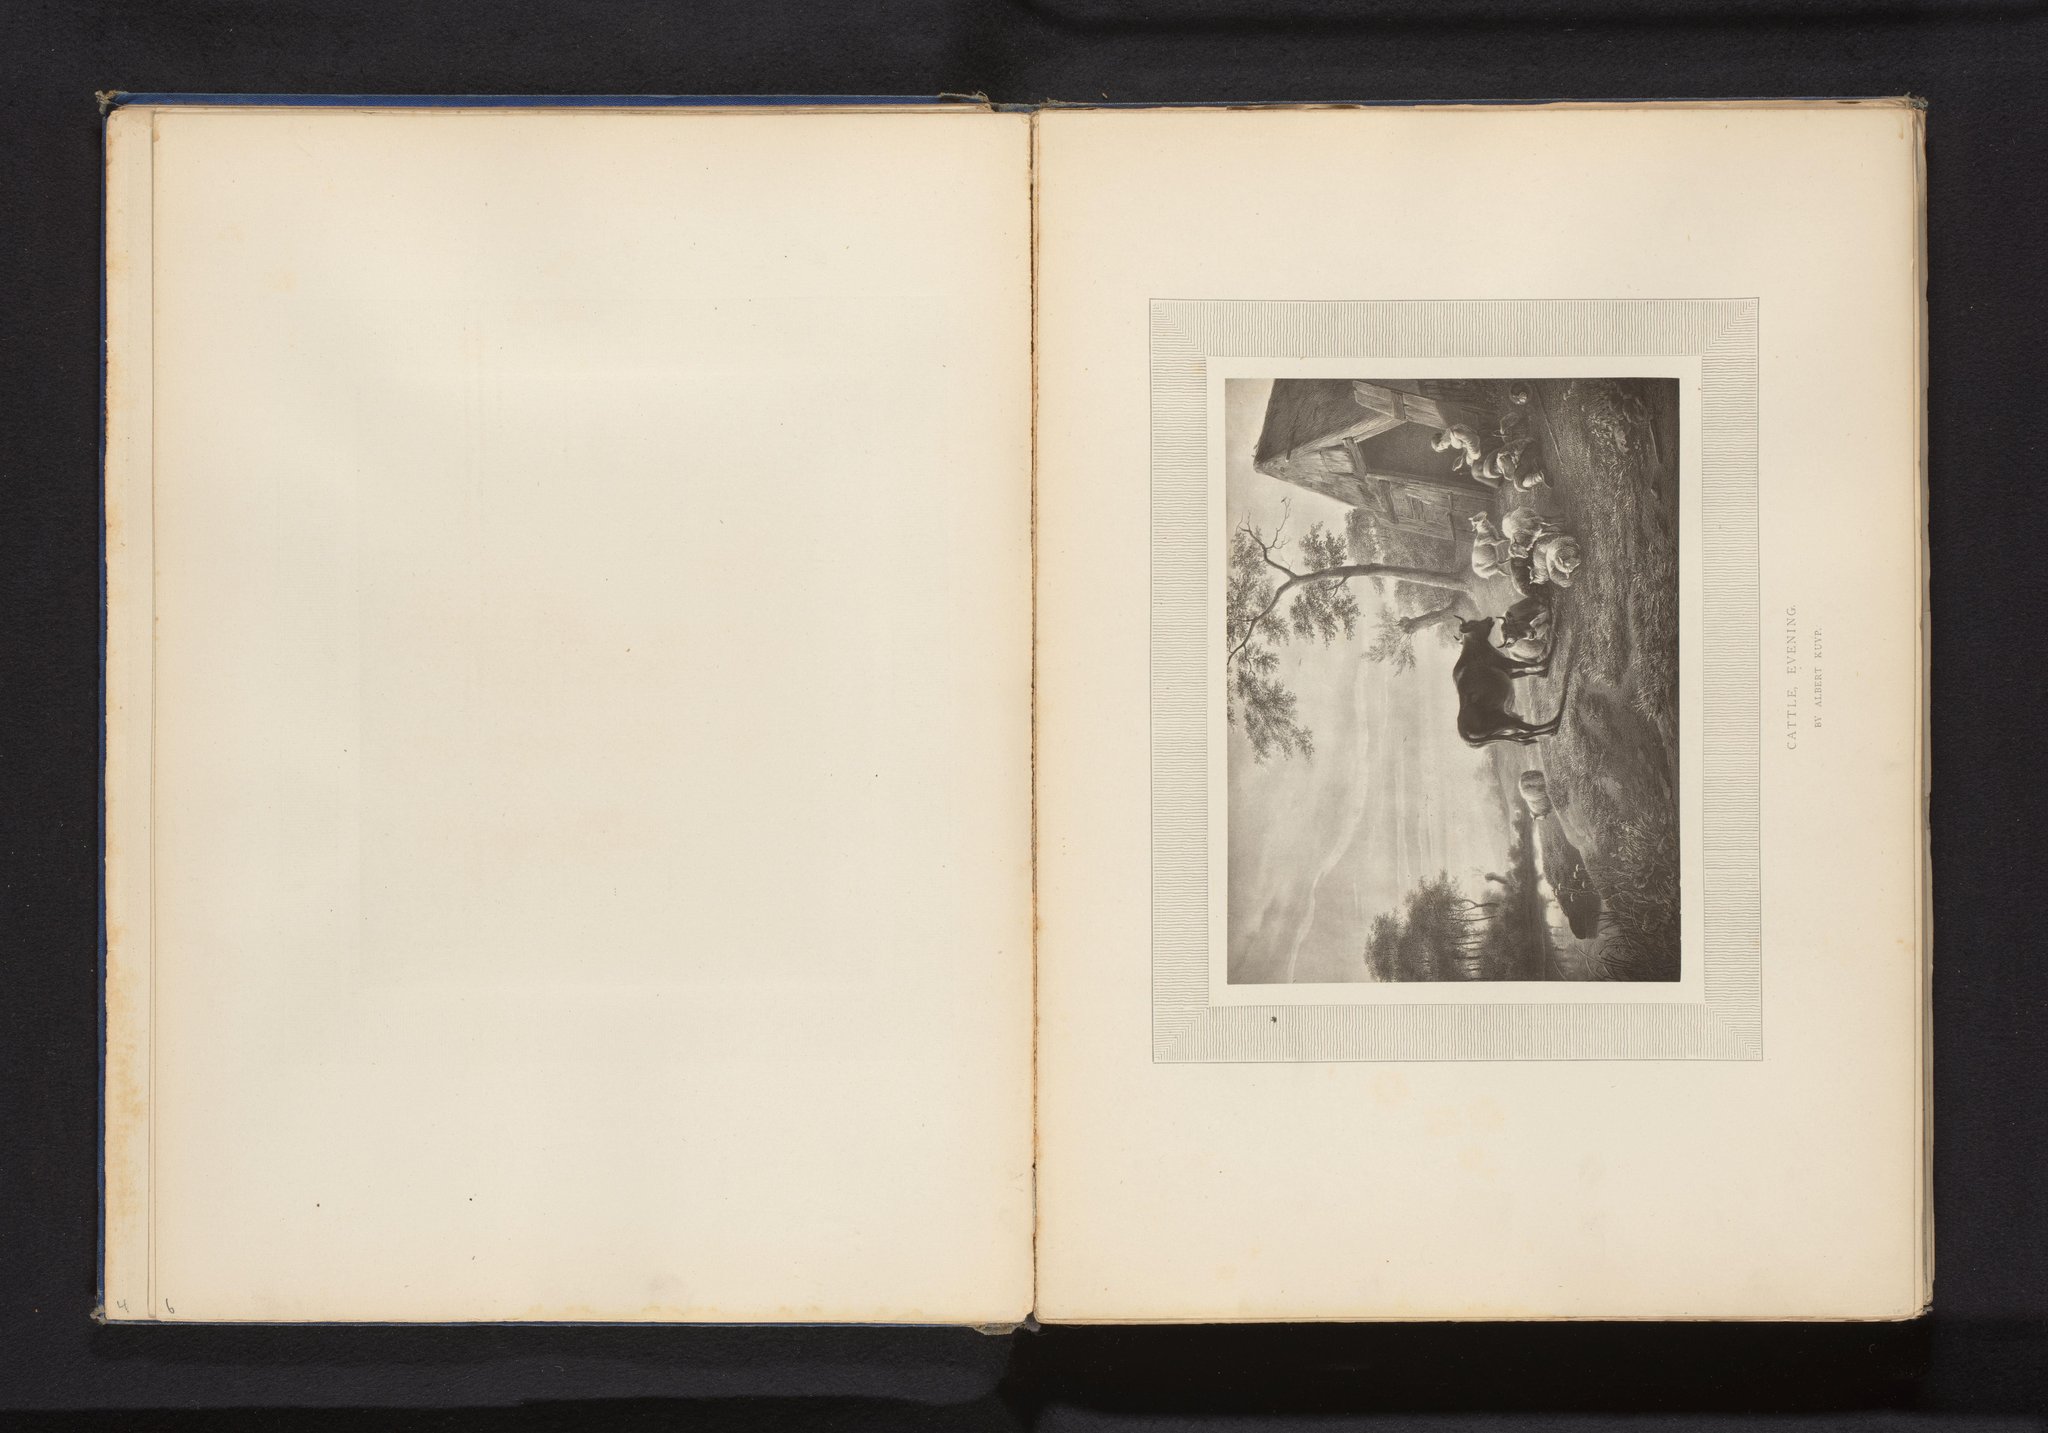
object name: page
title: Reproductie van een prent van vee bij een boerderij naar Aelbert Cuyp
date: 1870-1875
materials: paper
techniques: woodburytype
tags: sleeping on the ground - bb - out of doors, sheep, bovine cattle, farm or solitary house in landscape (+ city(-scape) with figures, staffage)